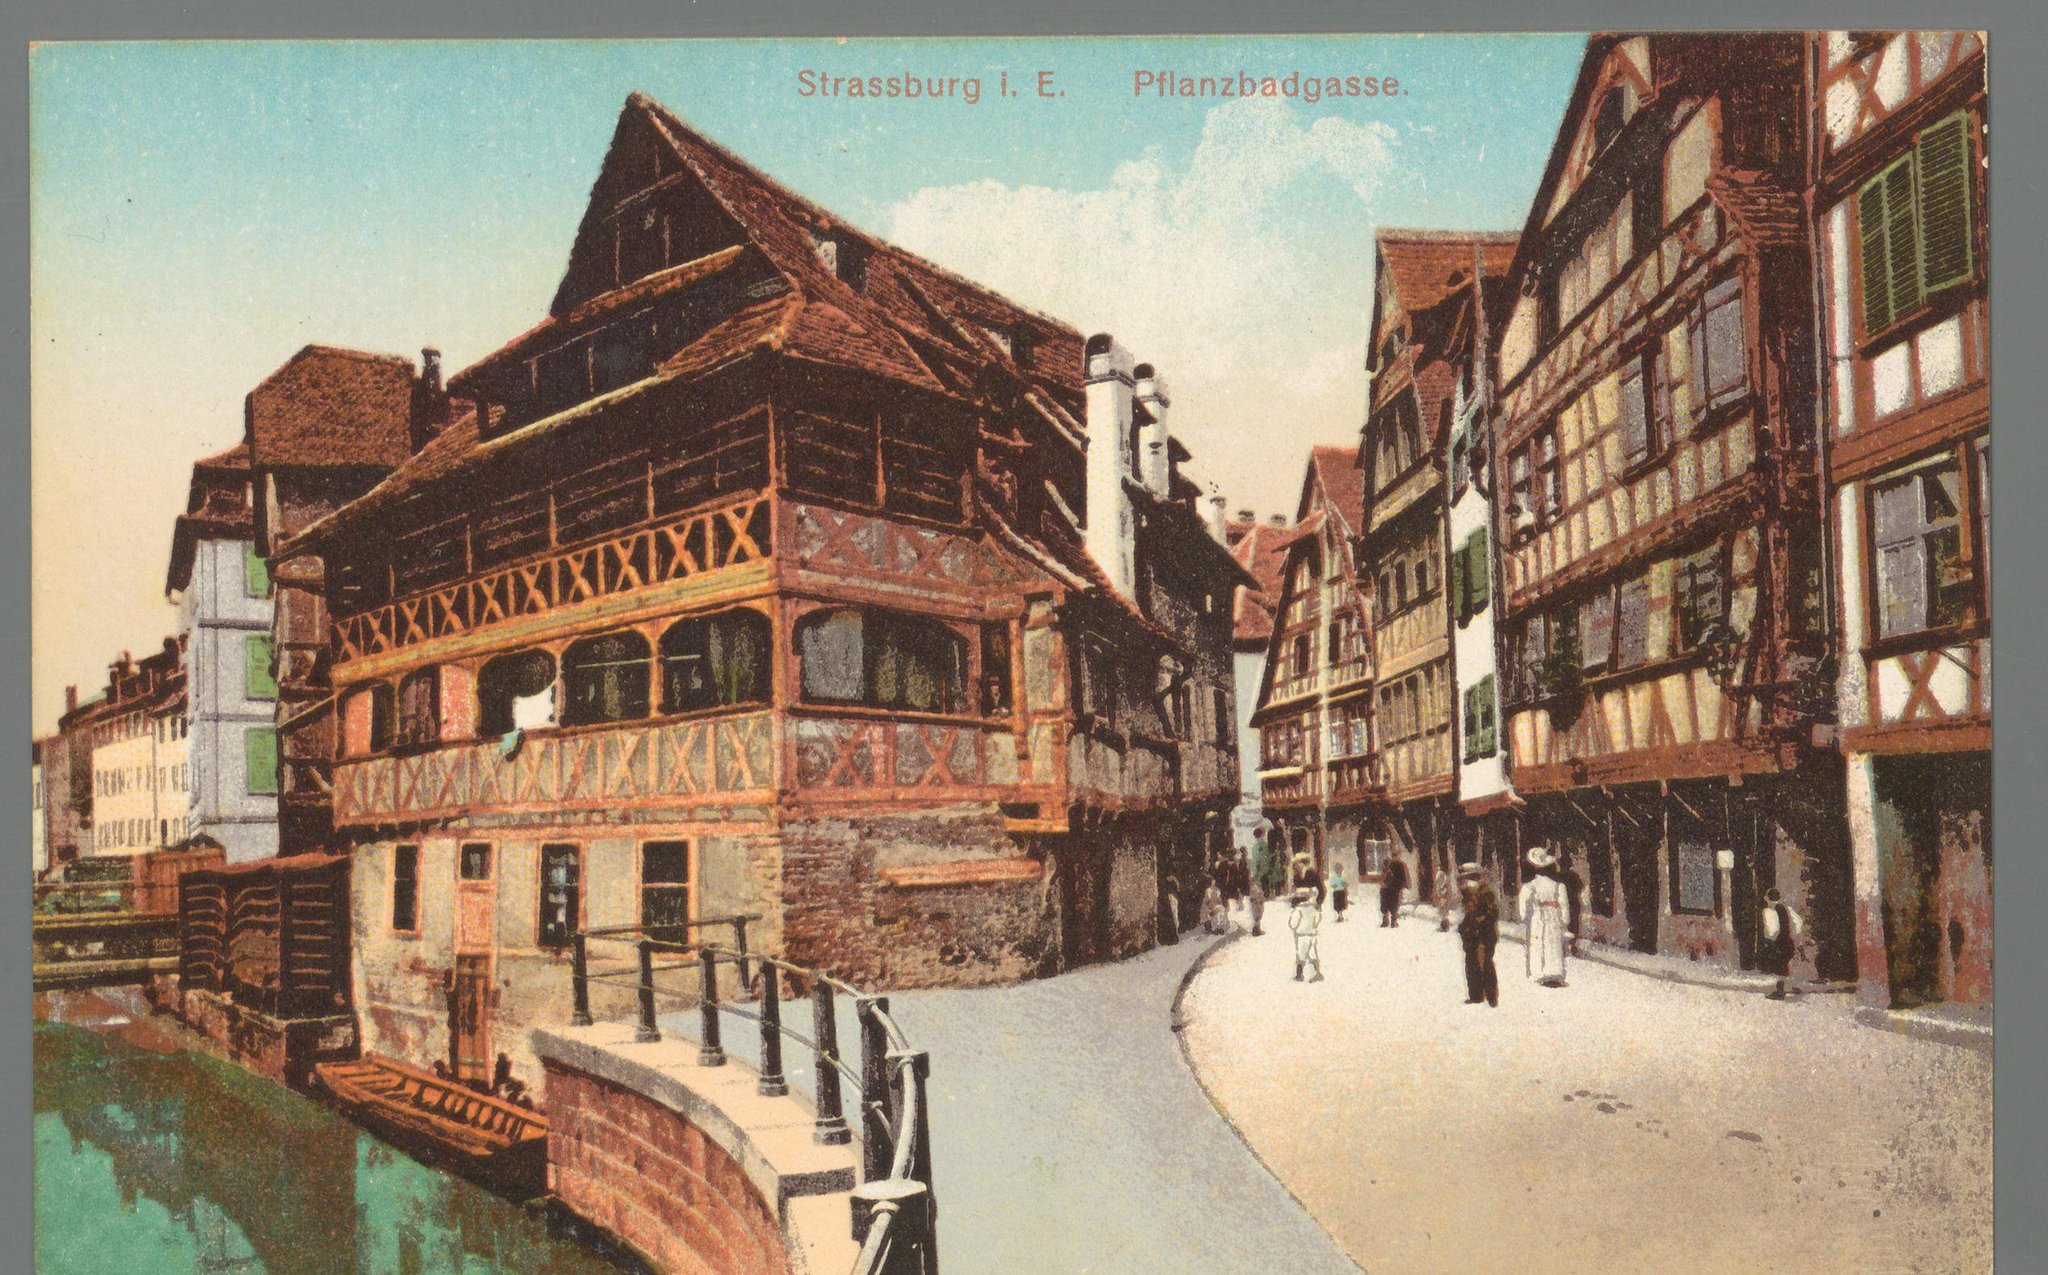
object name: print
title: Strassburg i. E. Pflanzbadgasse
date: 1905-1930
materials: cardboard, photographic process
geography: darmstadt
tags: canals, waters (in city), street